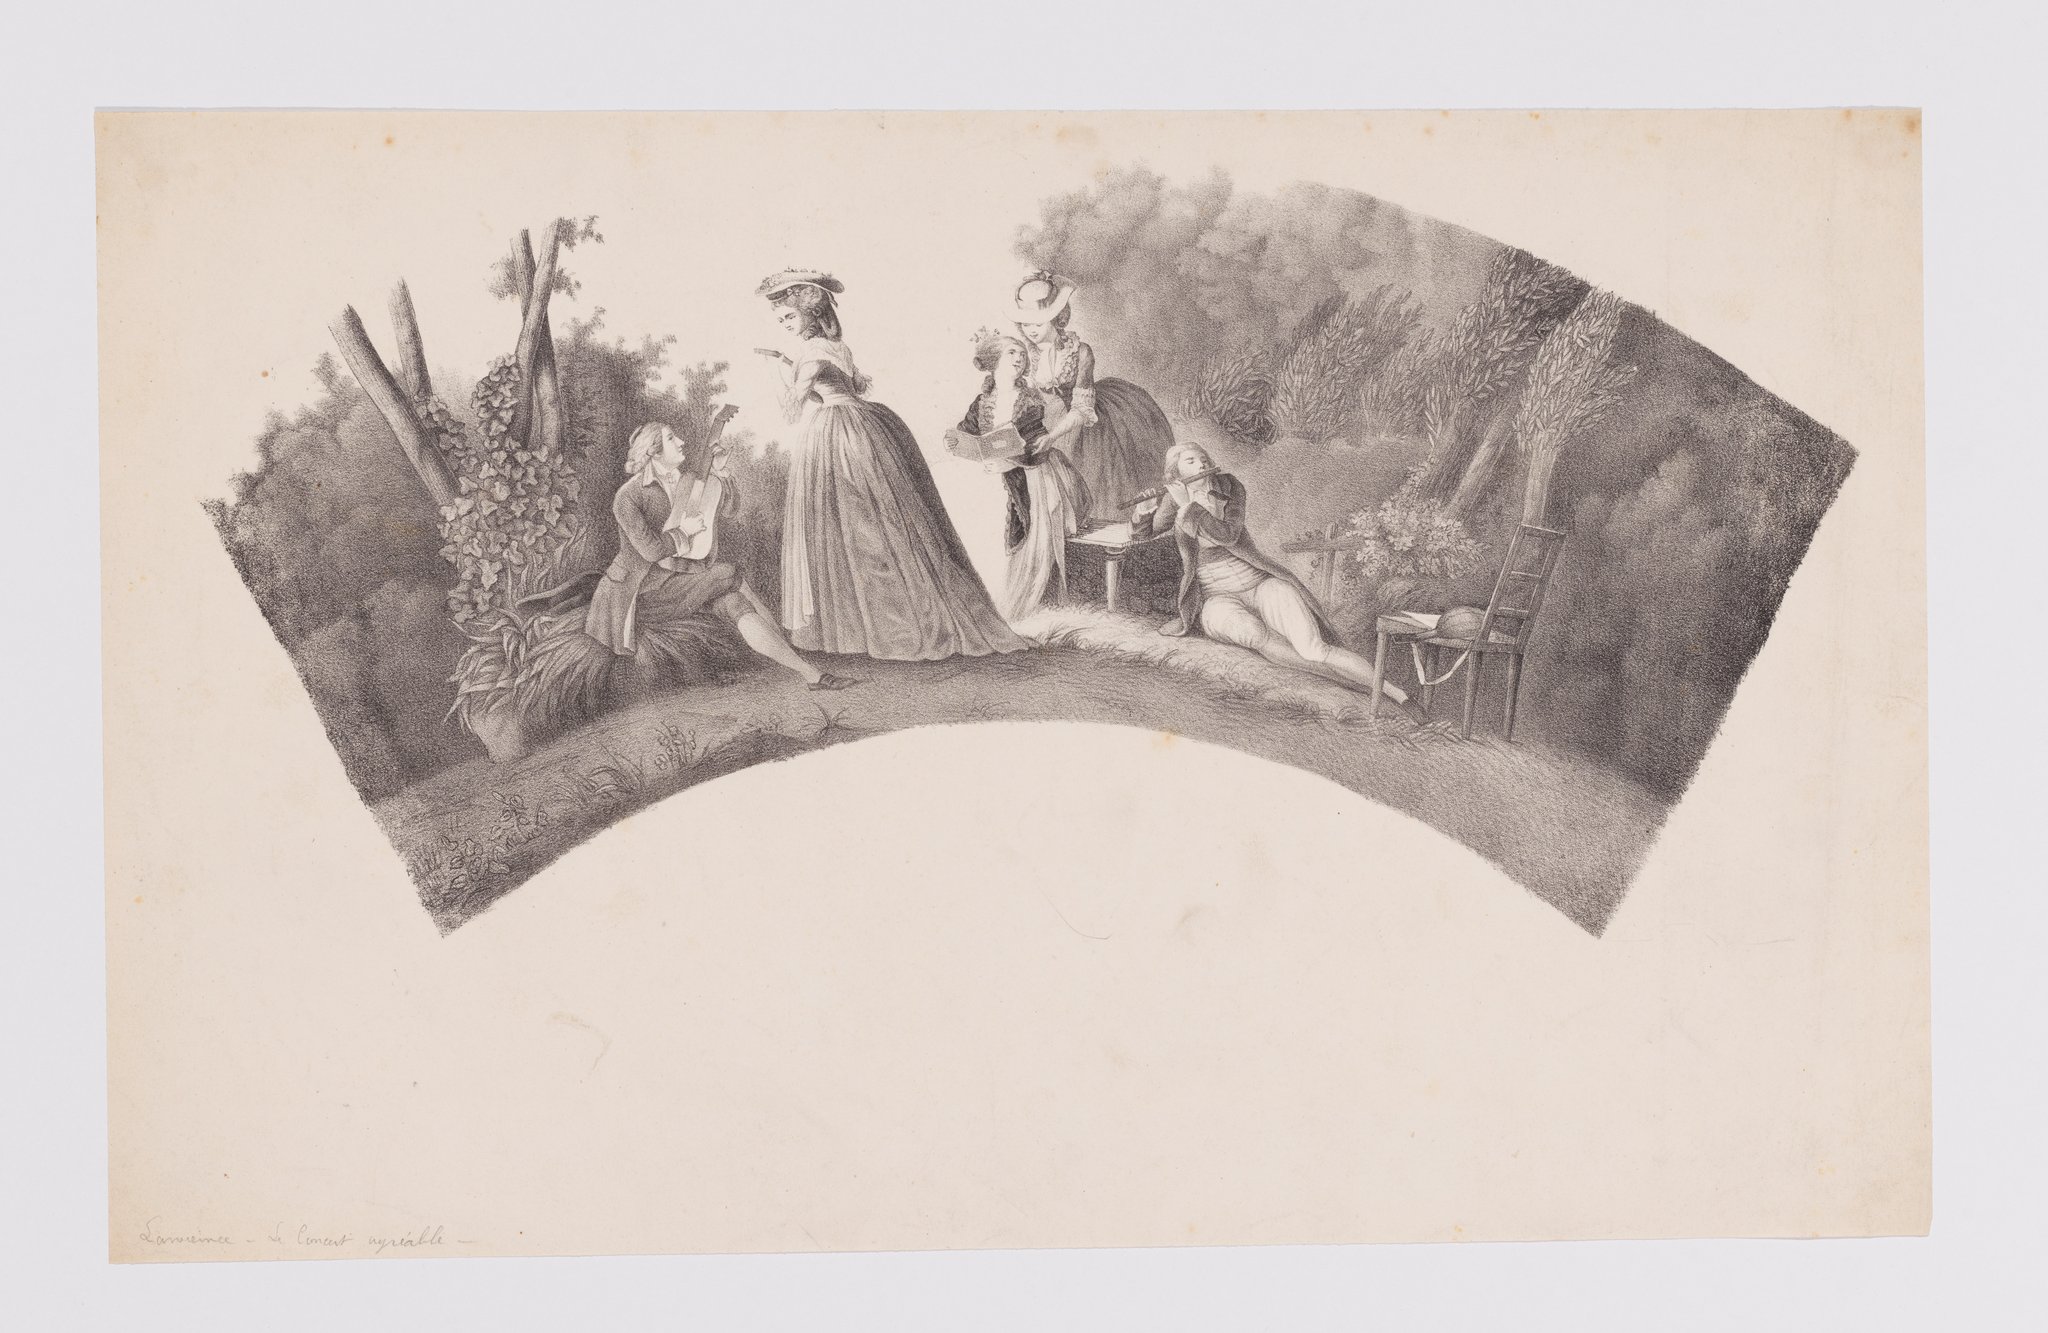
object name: print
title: Design for a fan after Le Concert Agreable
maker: anonymous, french, 19th century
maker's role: artist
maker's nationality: french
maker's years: 1800-1900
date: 1801-1900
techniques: lithograph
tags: musical instruments,men,women